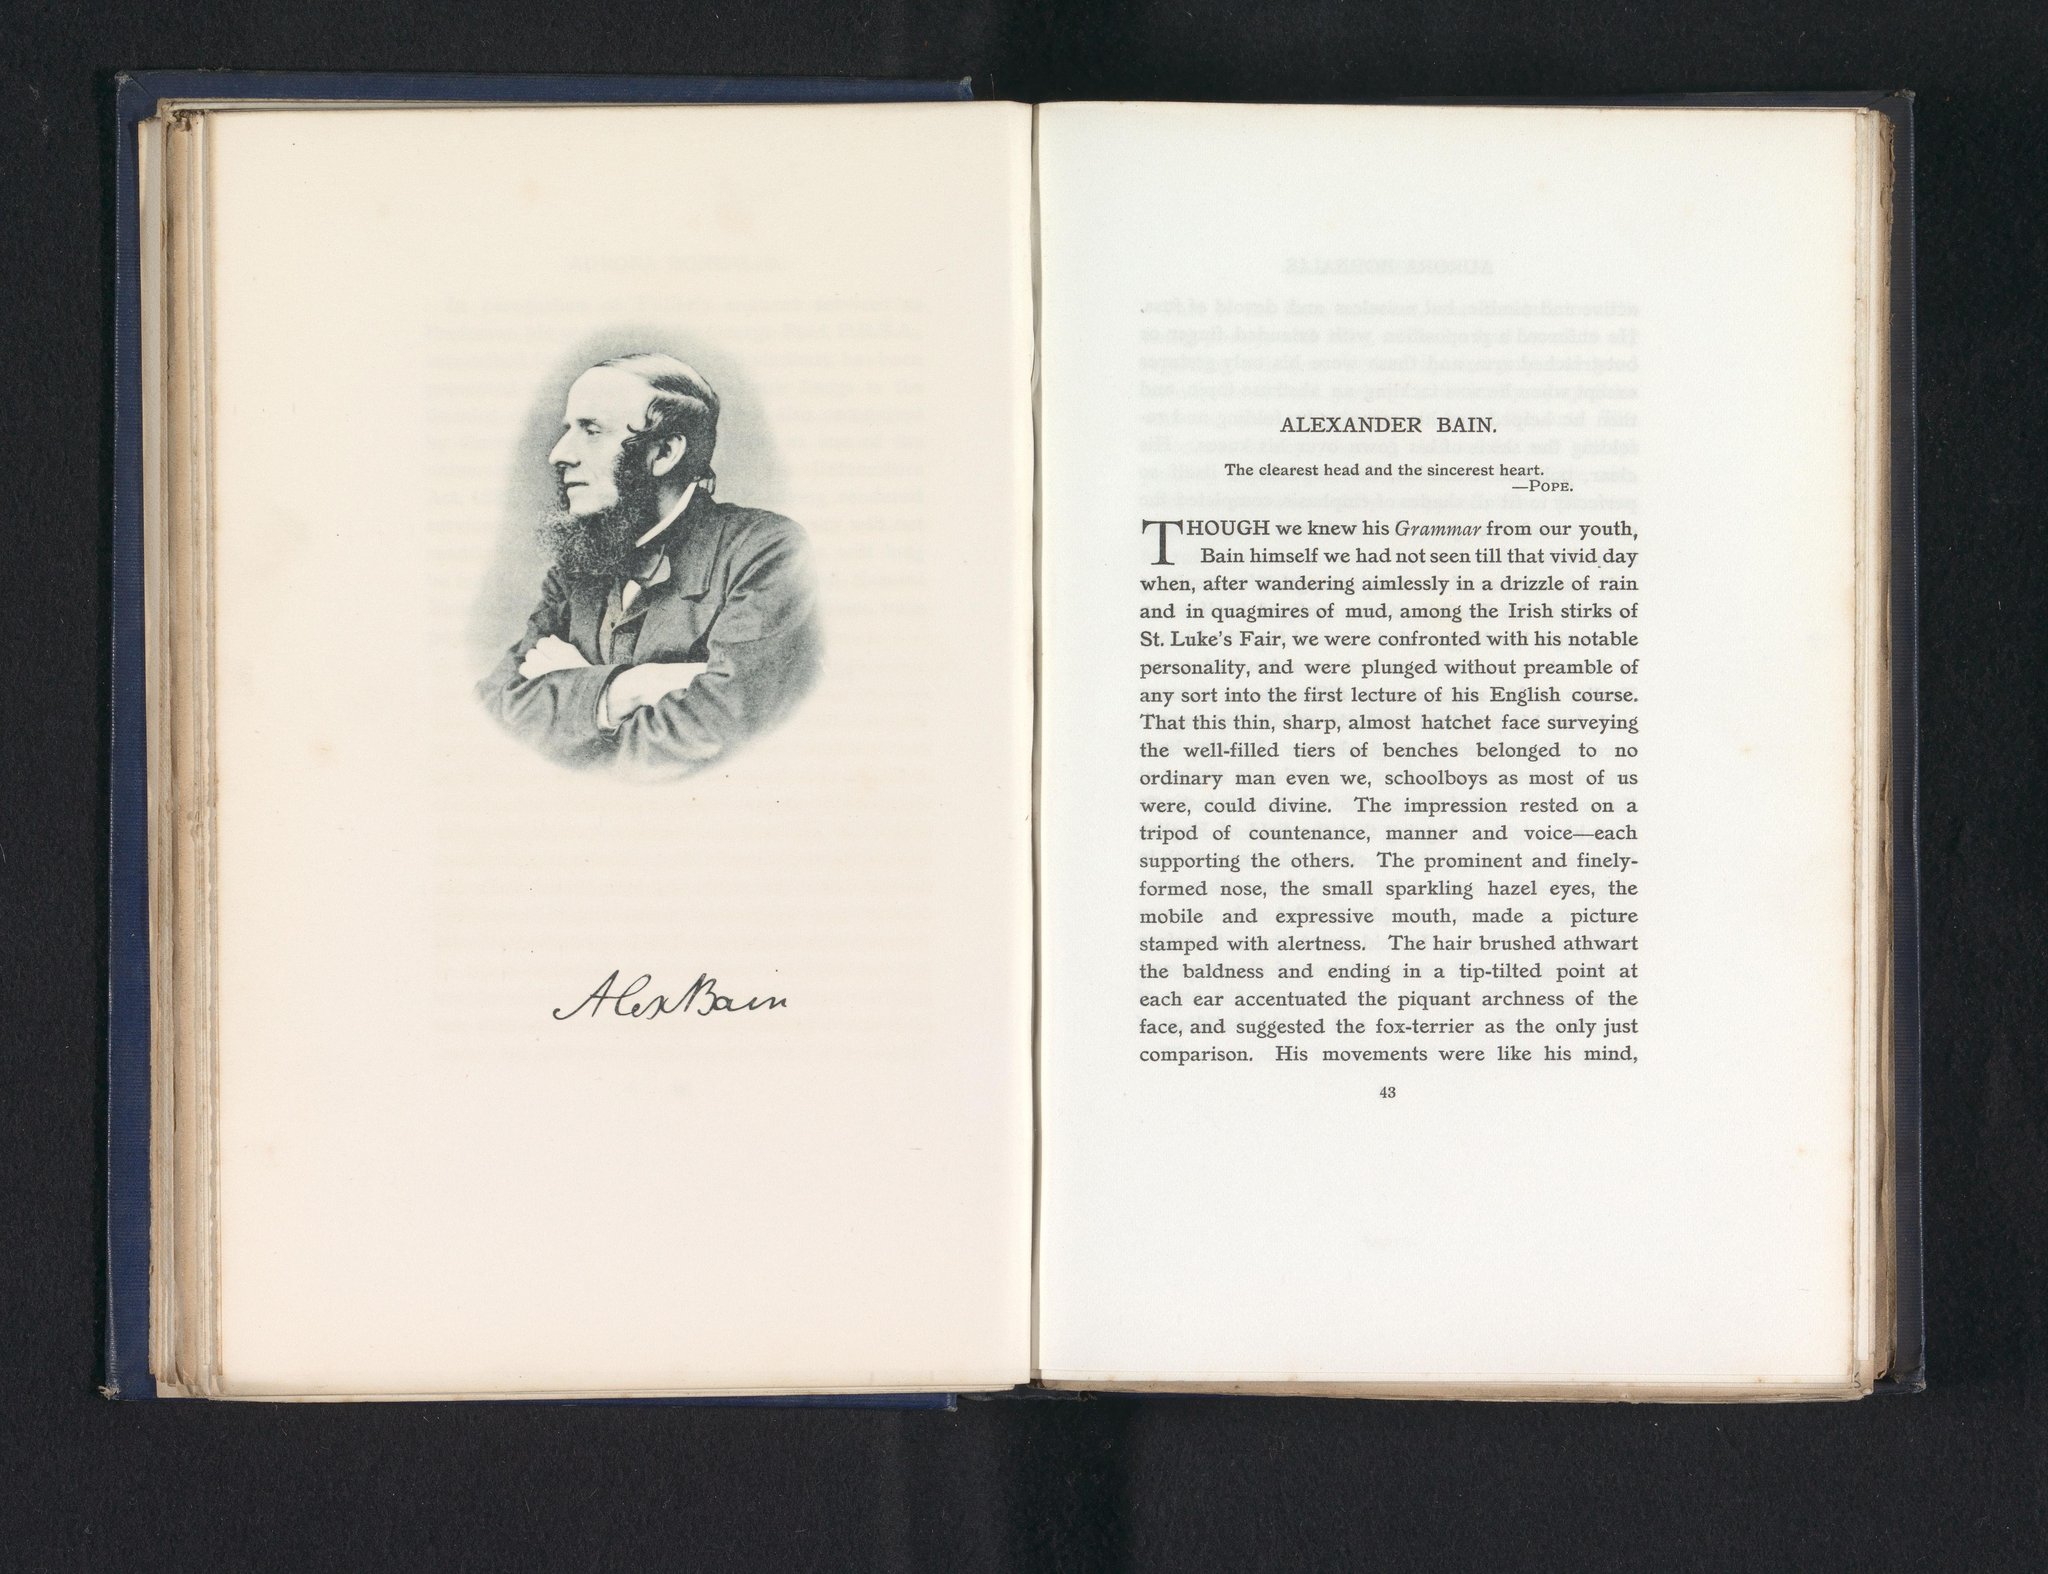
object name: photomechanical print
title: Portret van Alexander Bain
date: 1889-1899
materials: paper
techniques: photograph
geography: aberdeen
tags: scholar, philosopher